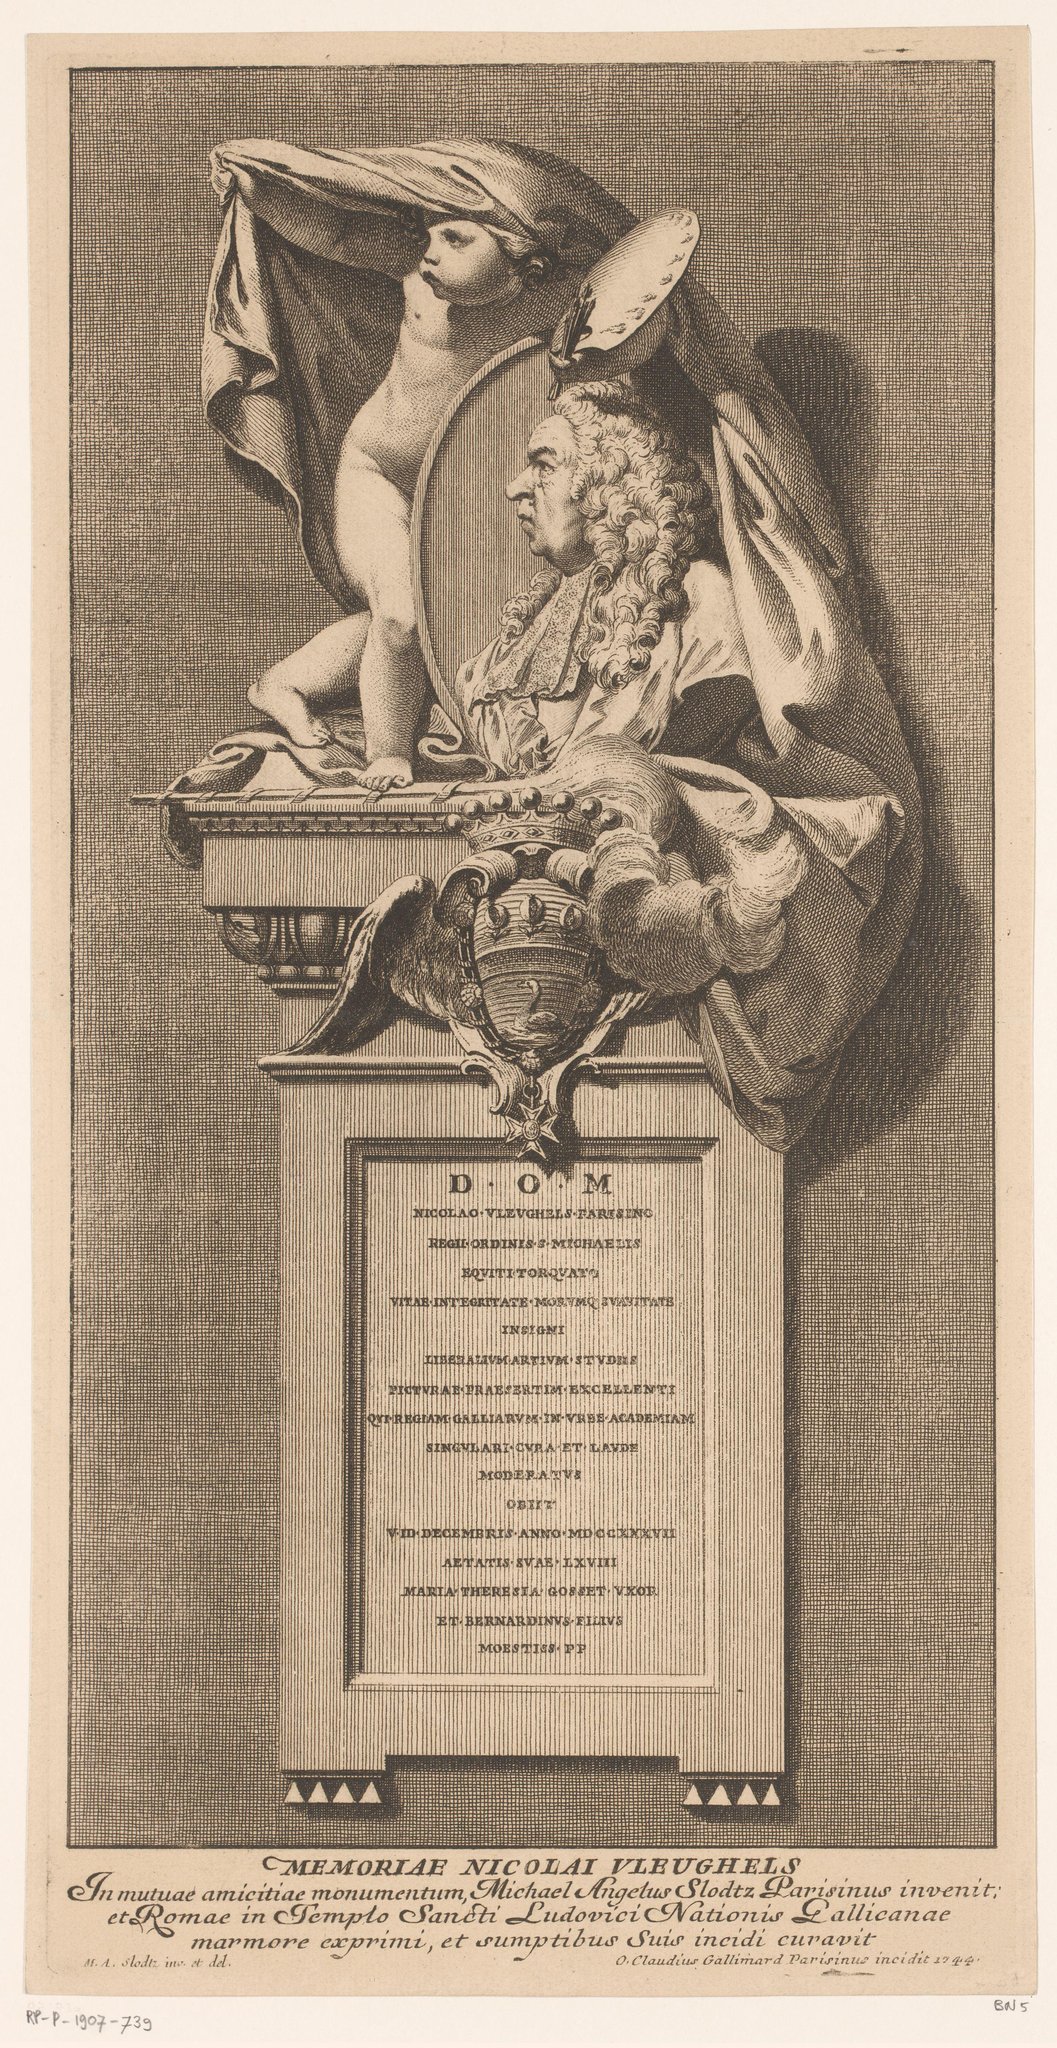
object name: print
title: Grafmonument van Nicolaas Vleughels in de San Luigi dei Francesi te Rome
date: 1744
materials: paper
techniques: engraving, etching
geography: paris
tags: paris, rome, painter, nicolas vleughels, historical persons, grave, tomb and other grave-forms and grave-markers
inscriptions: collector's mark: Lugt 2228